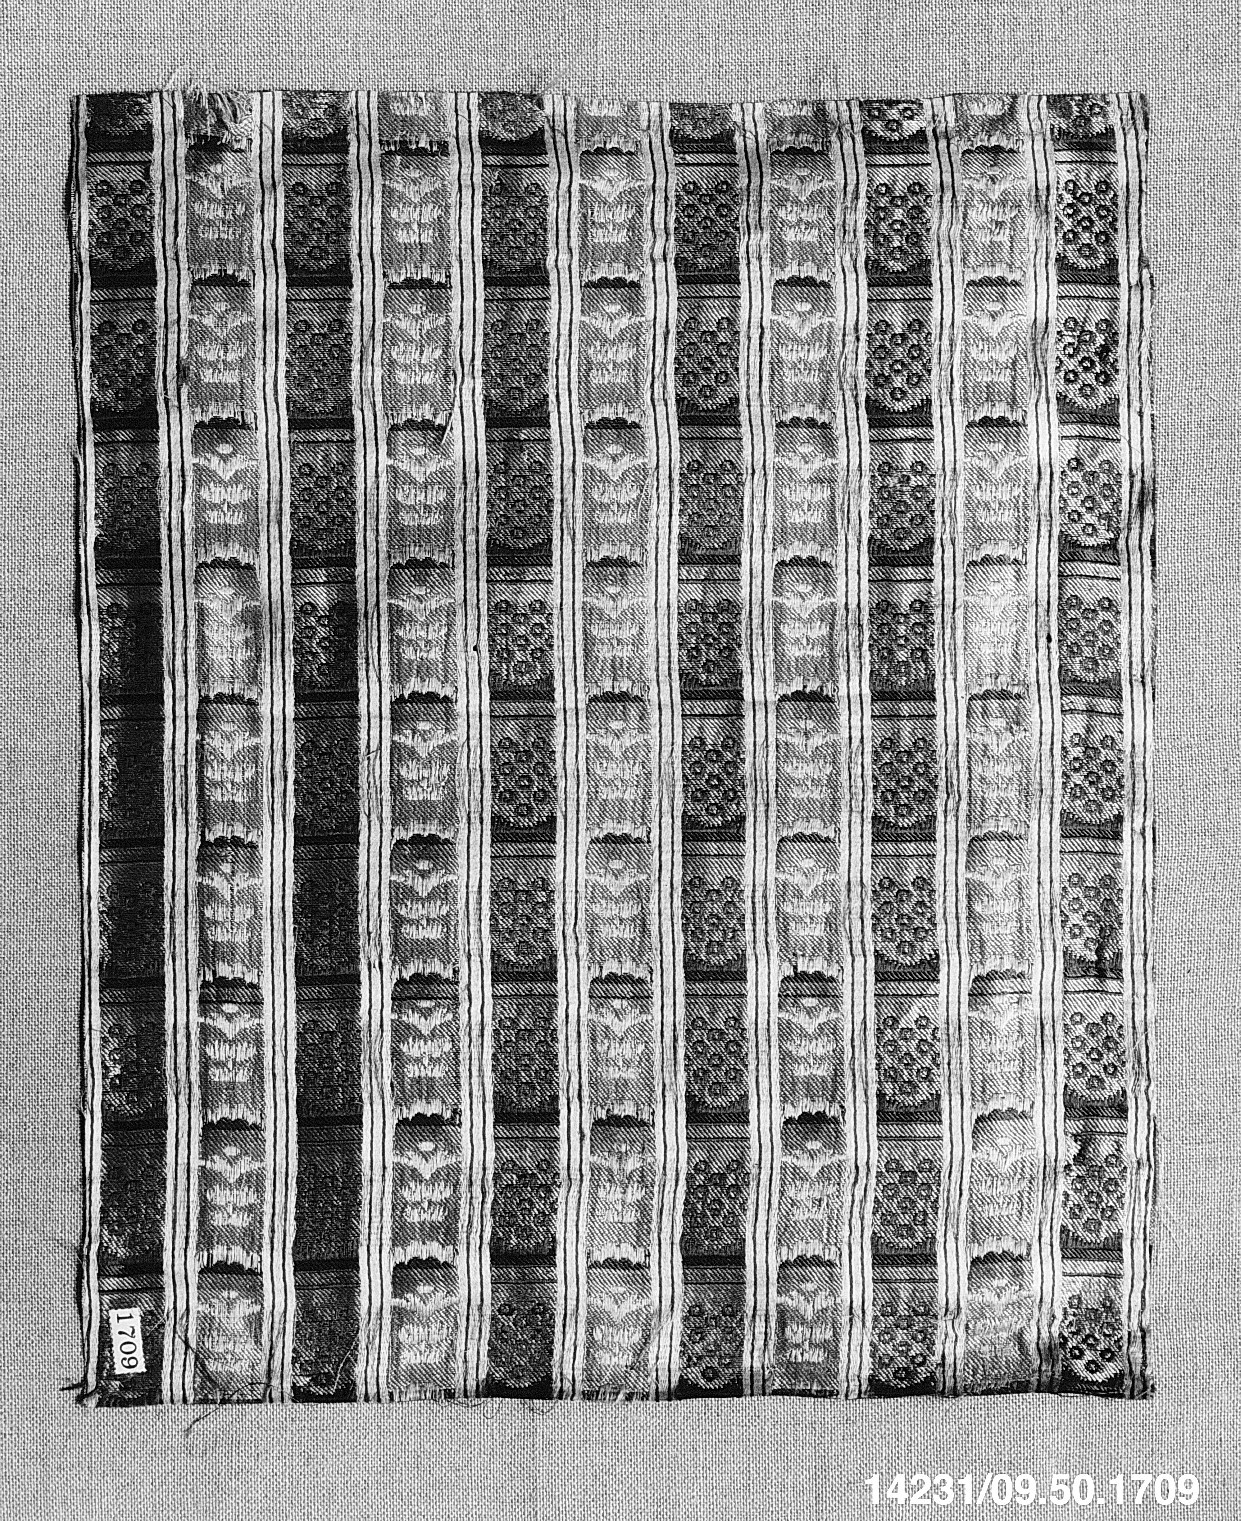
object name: piece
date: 1701-1800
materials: silk